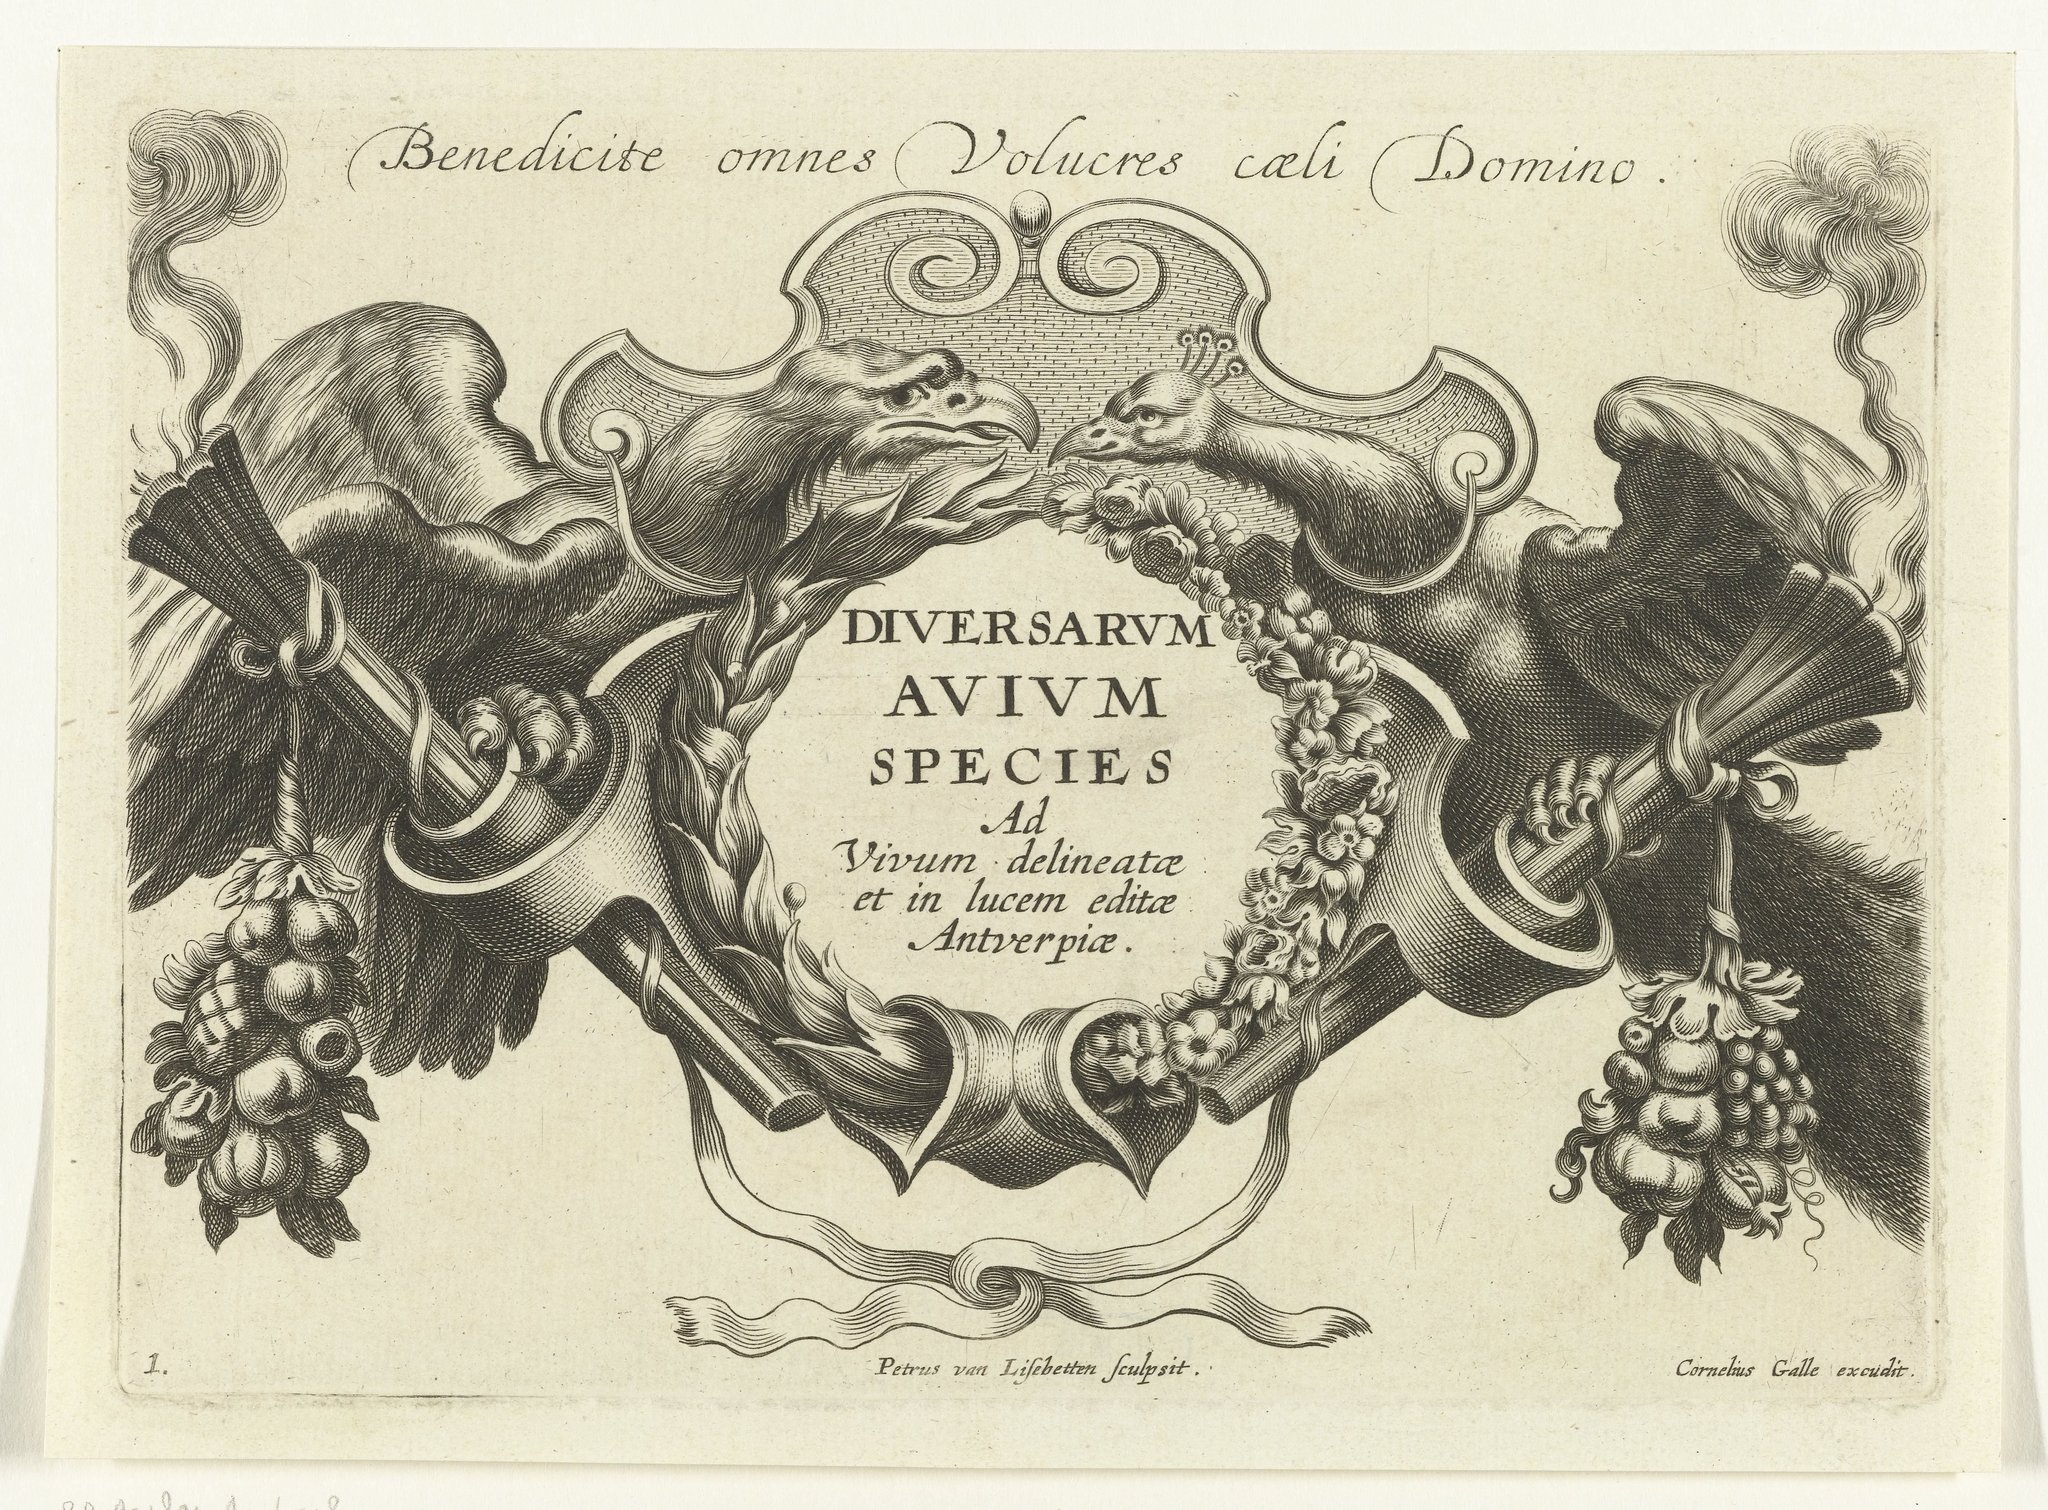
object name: titelprent, frontispice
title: Diversarum avium species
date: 1654-1678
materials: paper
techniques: engraving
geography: antwerp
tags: predatory birds: eagle, birds, ornamental birds: peacock, ornament ~ cartouche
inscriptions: collector's mark: Lugt 2228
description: Cartouche met de titel van de serie, geflankeerd door links een arend en rechts een pauw. De cartouche is versierd met brandende fakkels en guirlandes van vruchten.